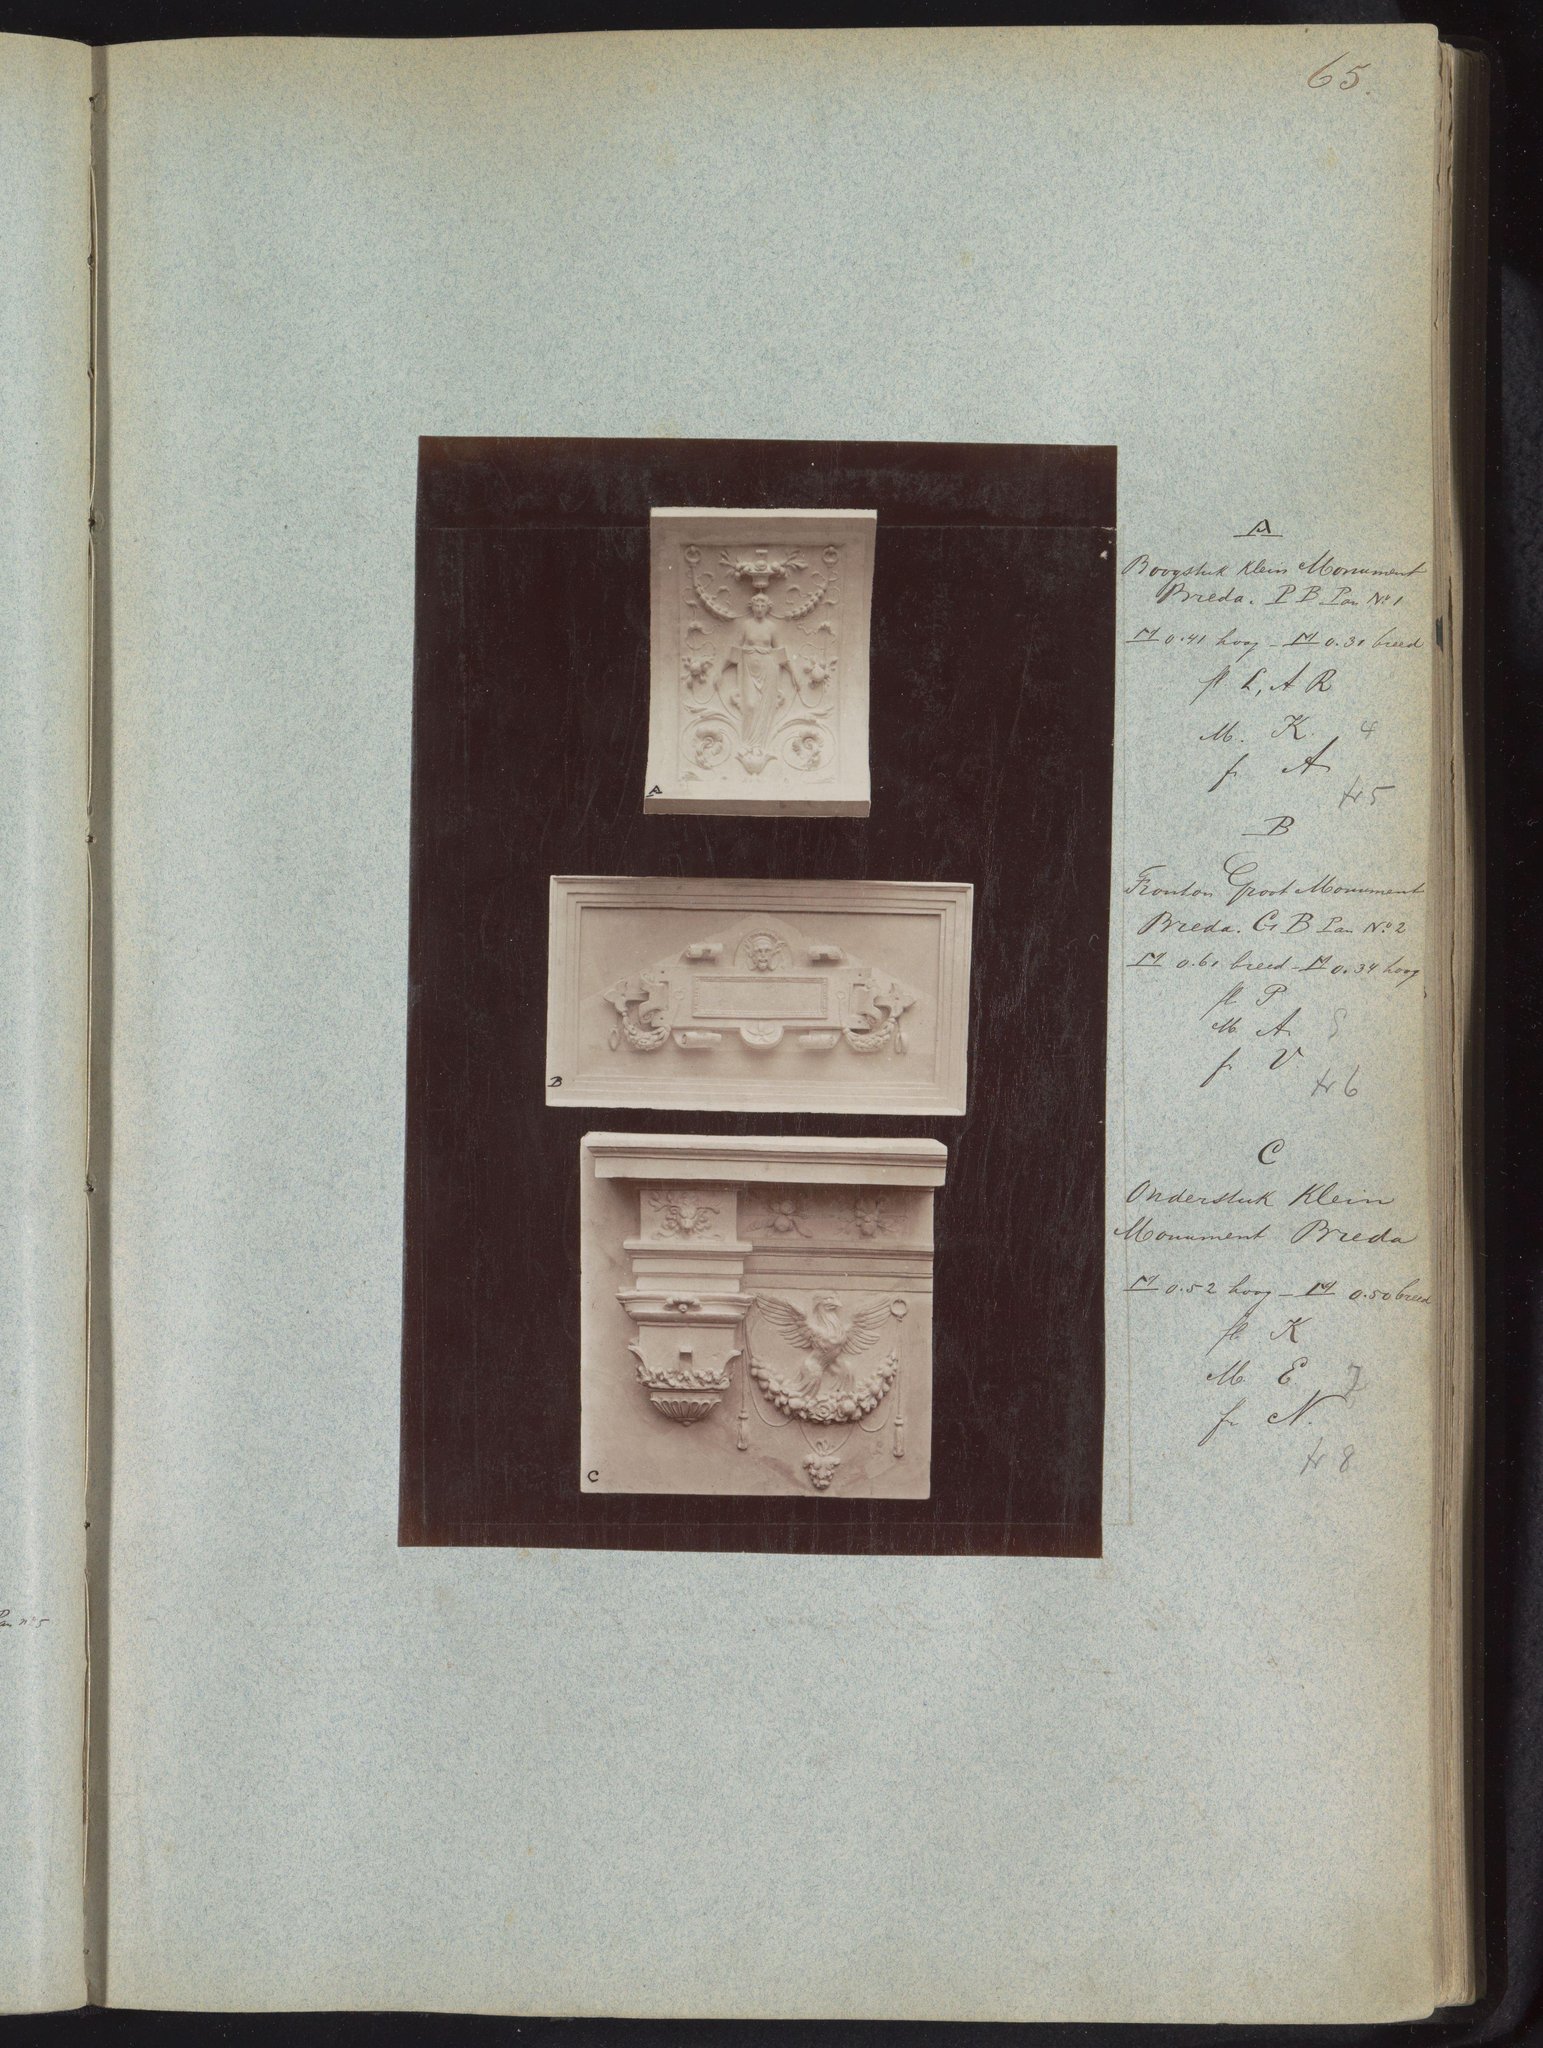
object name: photograph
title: Gipsen afgietsels van een boogstuk, fronton en onderstuk van één of meerdere monumenten te Breda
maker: Anonymous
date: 1875-1900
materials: paper, photographic support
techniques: albumen print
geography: breda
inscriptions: annotation: ‘A / Boogstuk Klein Monument / Breda / M 0.41 hoog - M 0.1 breed’, annotation: ‘C / Onderstuk Klein / Monument Breda / M 0.52 hoog - 0.50 breed’, annotation, annotation: ‘B / Fronton Groot Monument / Breda / M 0.61 breed - M 0.34 hoog’